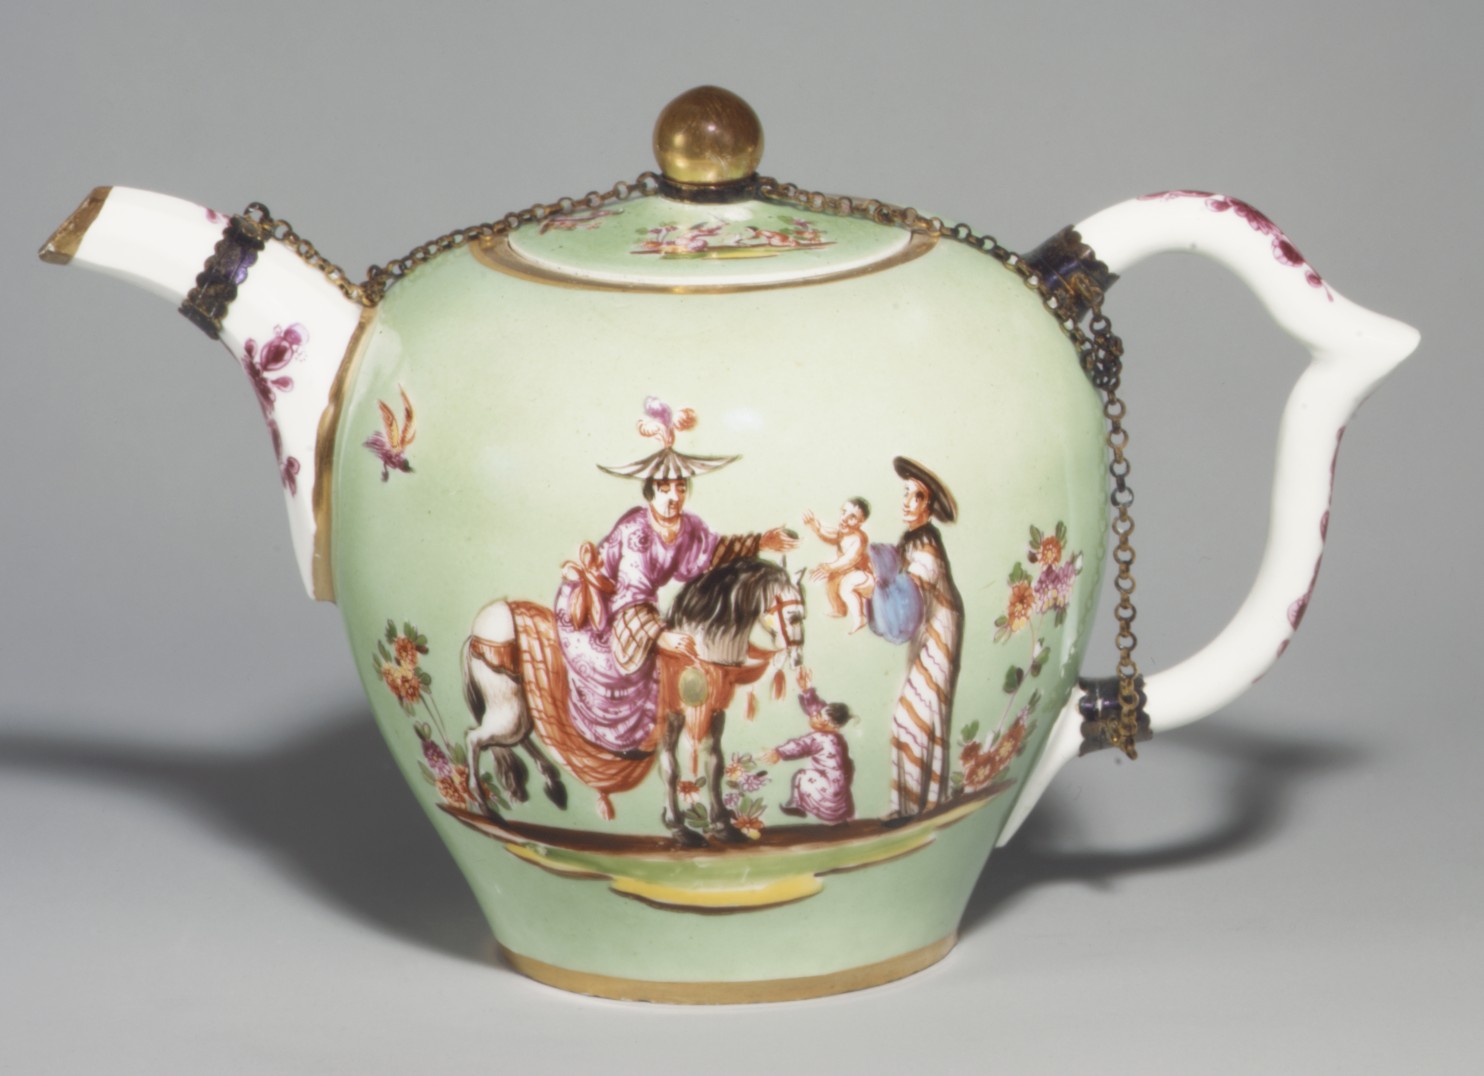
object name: teapot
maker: meissen manufactory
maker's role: manufactory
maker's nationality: german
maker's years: 1710-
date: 1735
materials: hard paste porcelain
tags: infants,men,women,horses